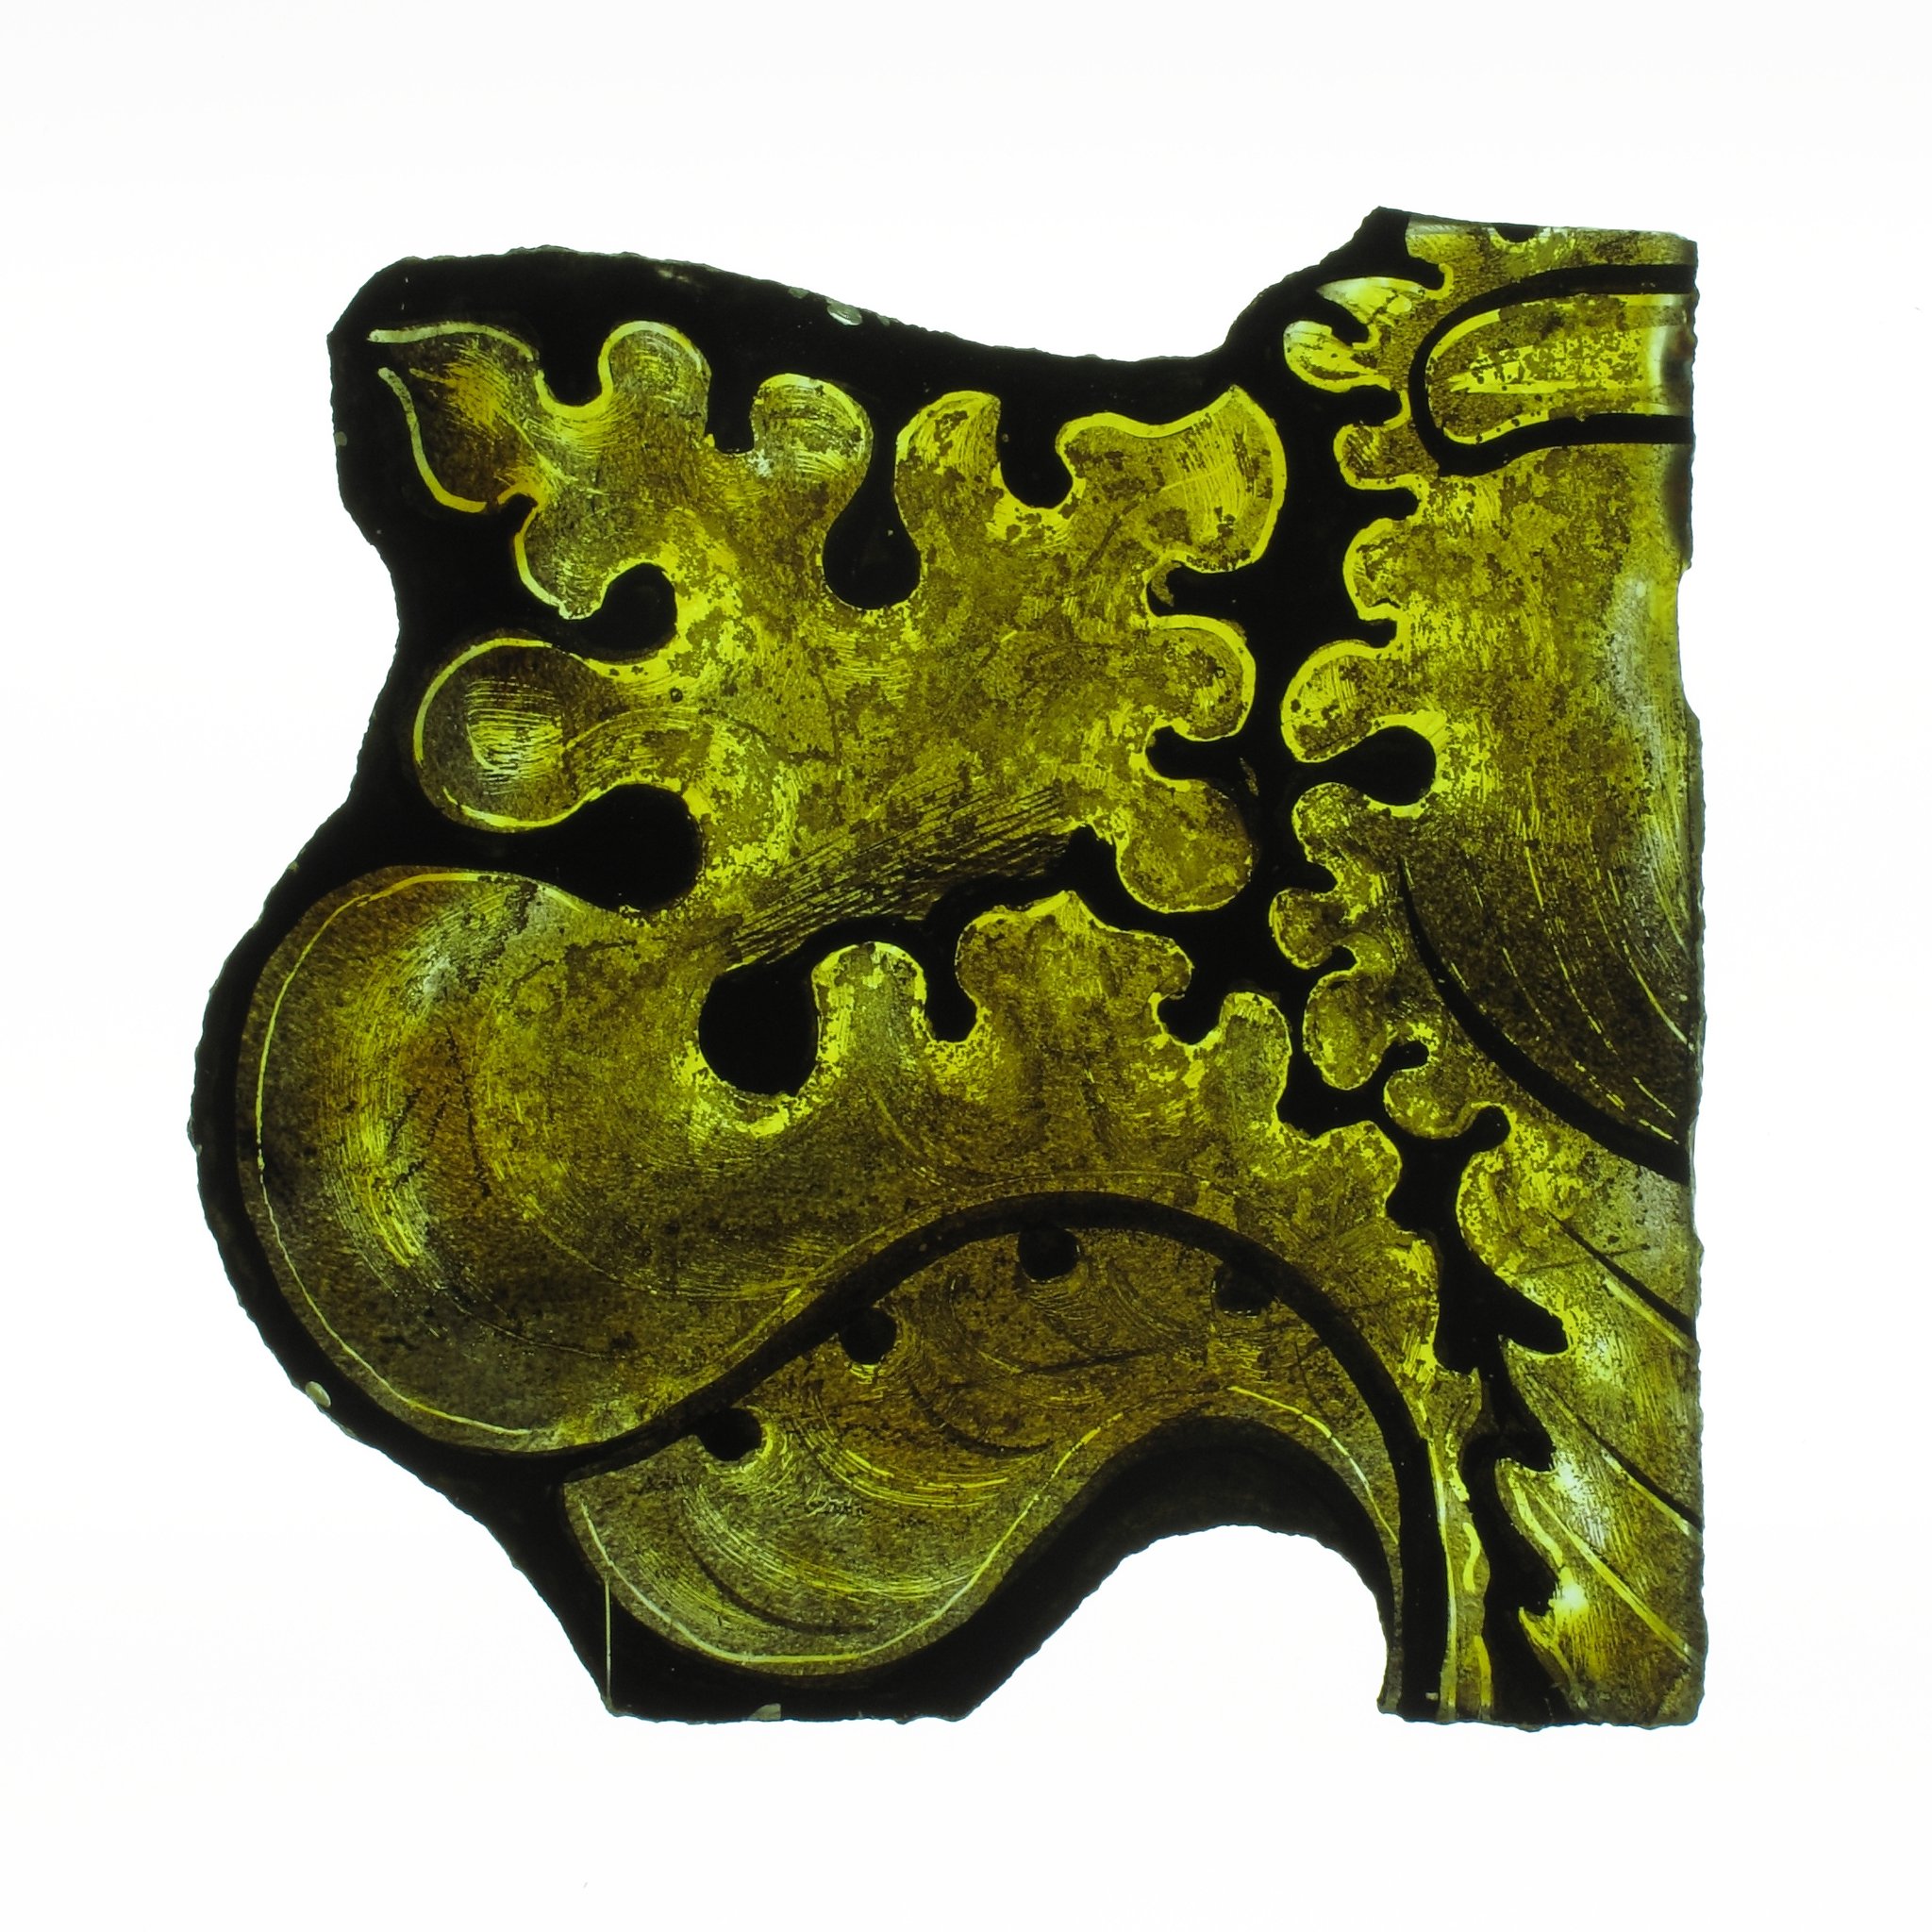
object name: fragment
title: Glass Fragment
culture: french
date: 1101-1400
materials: glass, metal, paint